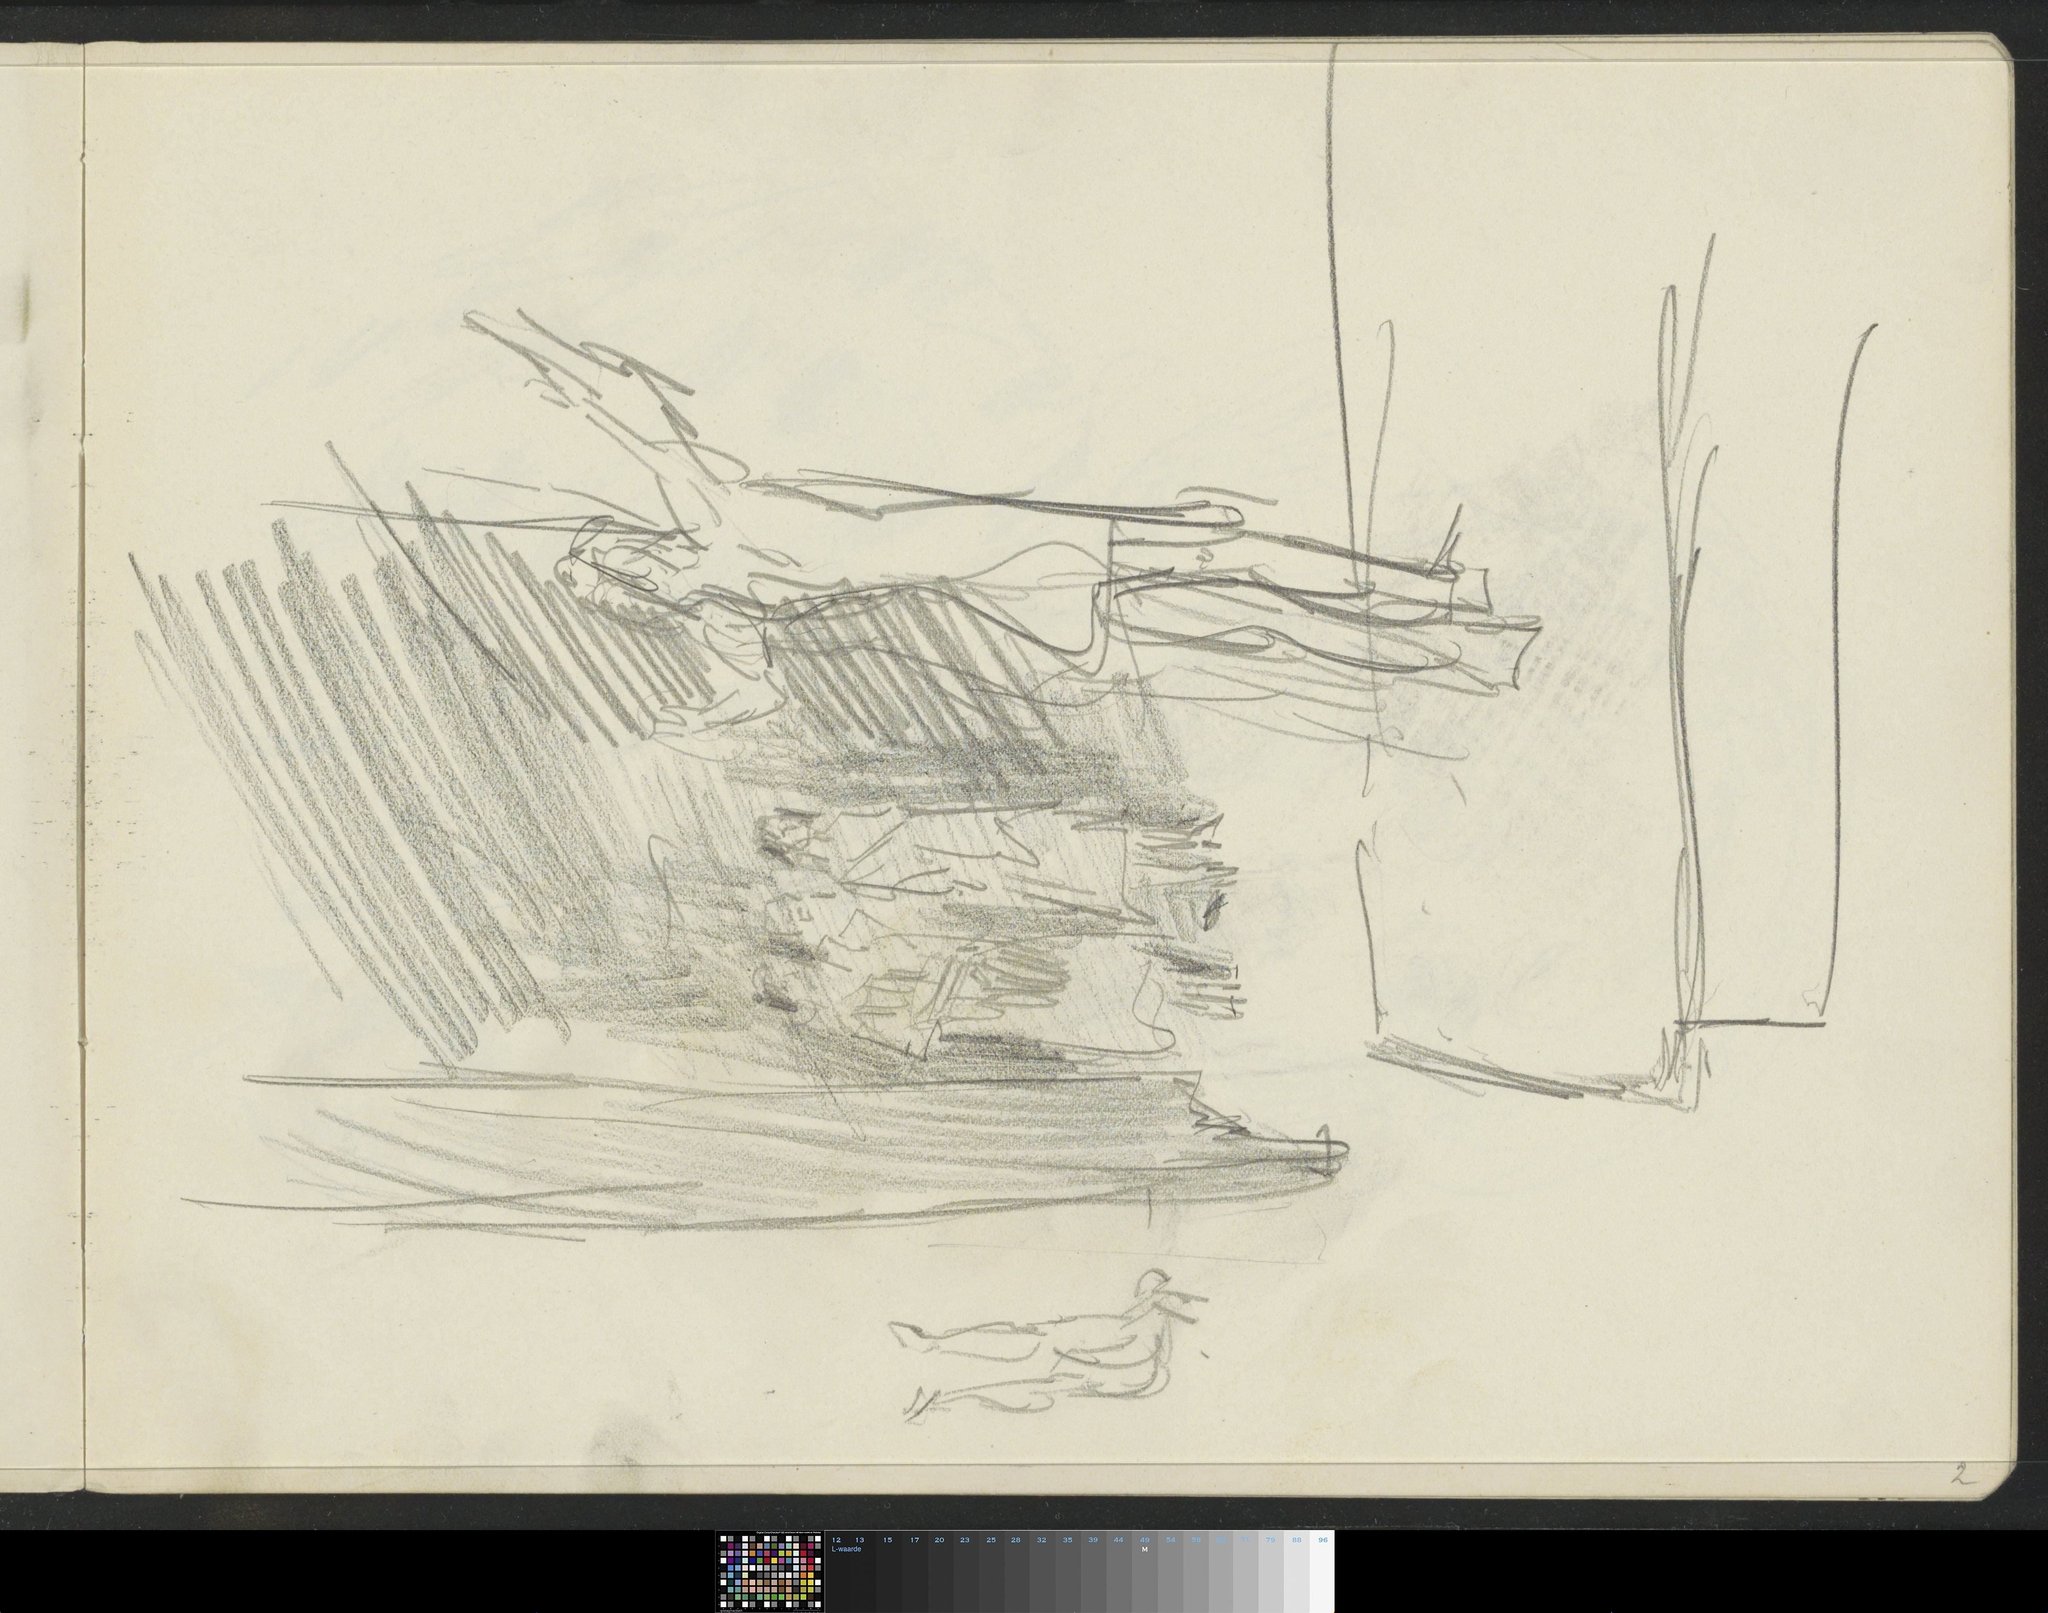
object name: sketchbook leaf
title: Vrouw op een verhoging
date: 1915-1934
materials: paper, pencil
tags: adult woman (+ standing), the stage and its equipment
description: Ze houdt haar armen in de lucht. Op de achtergrond enkele vrouwen, mogelijk tussen coulissen. Blad 2 recto uit schetsboek XVI met 32 bladen.